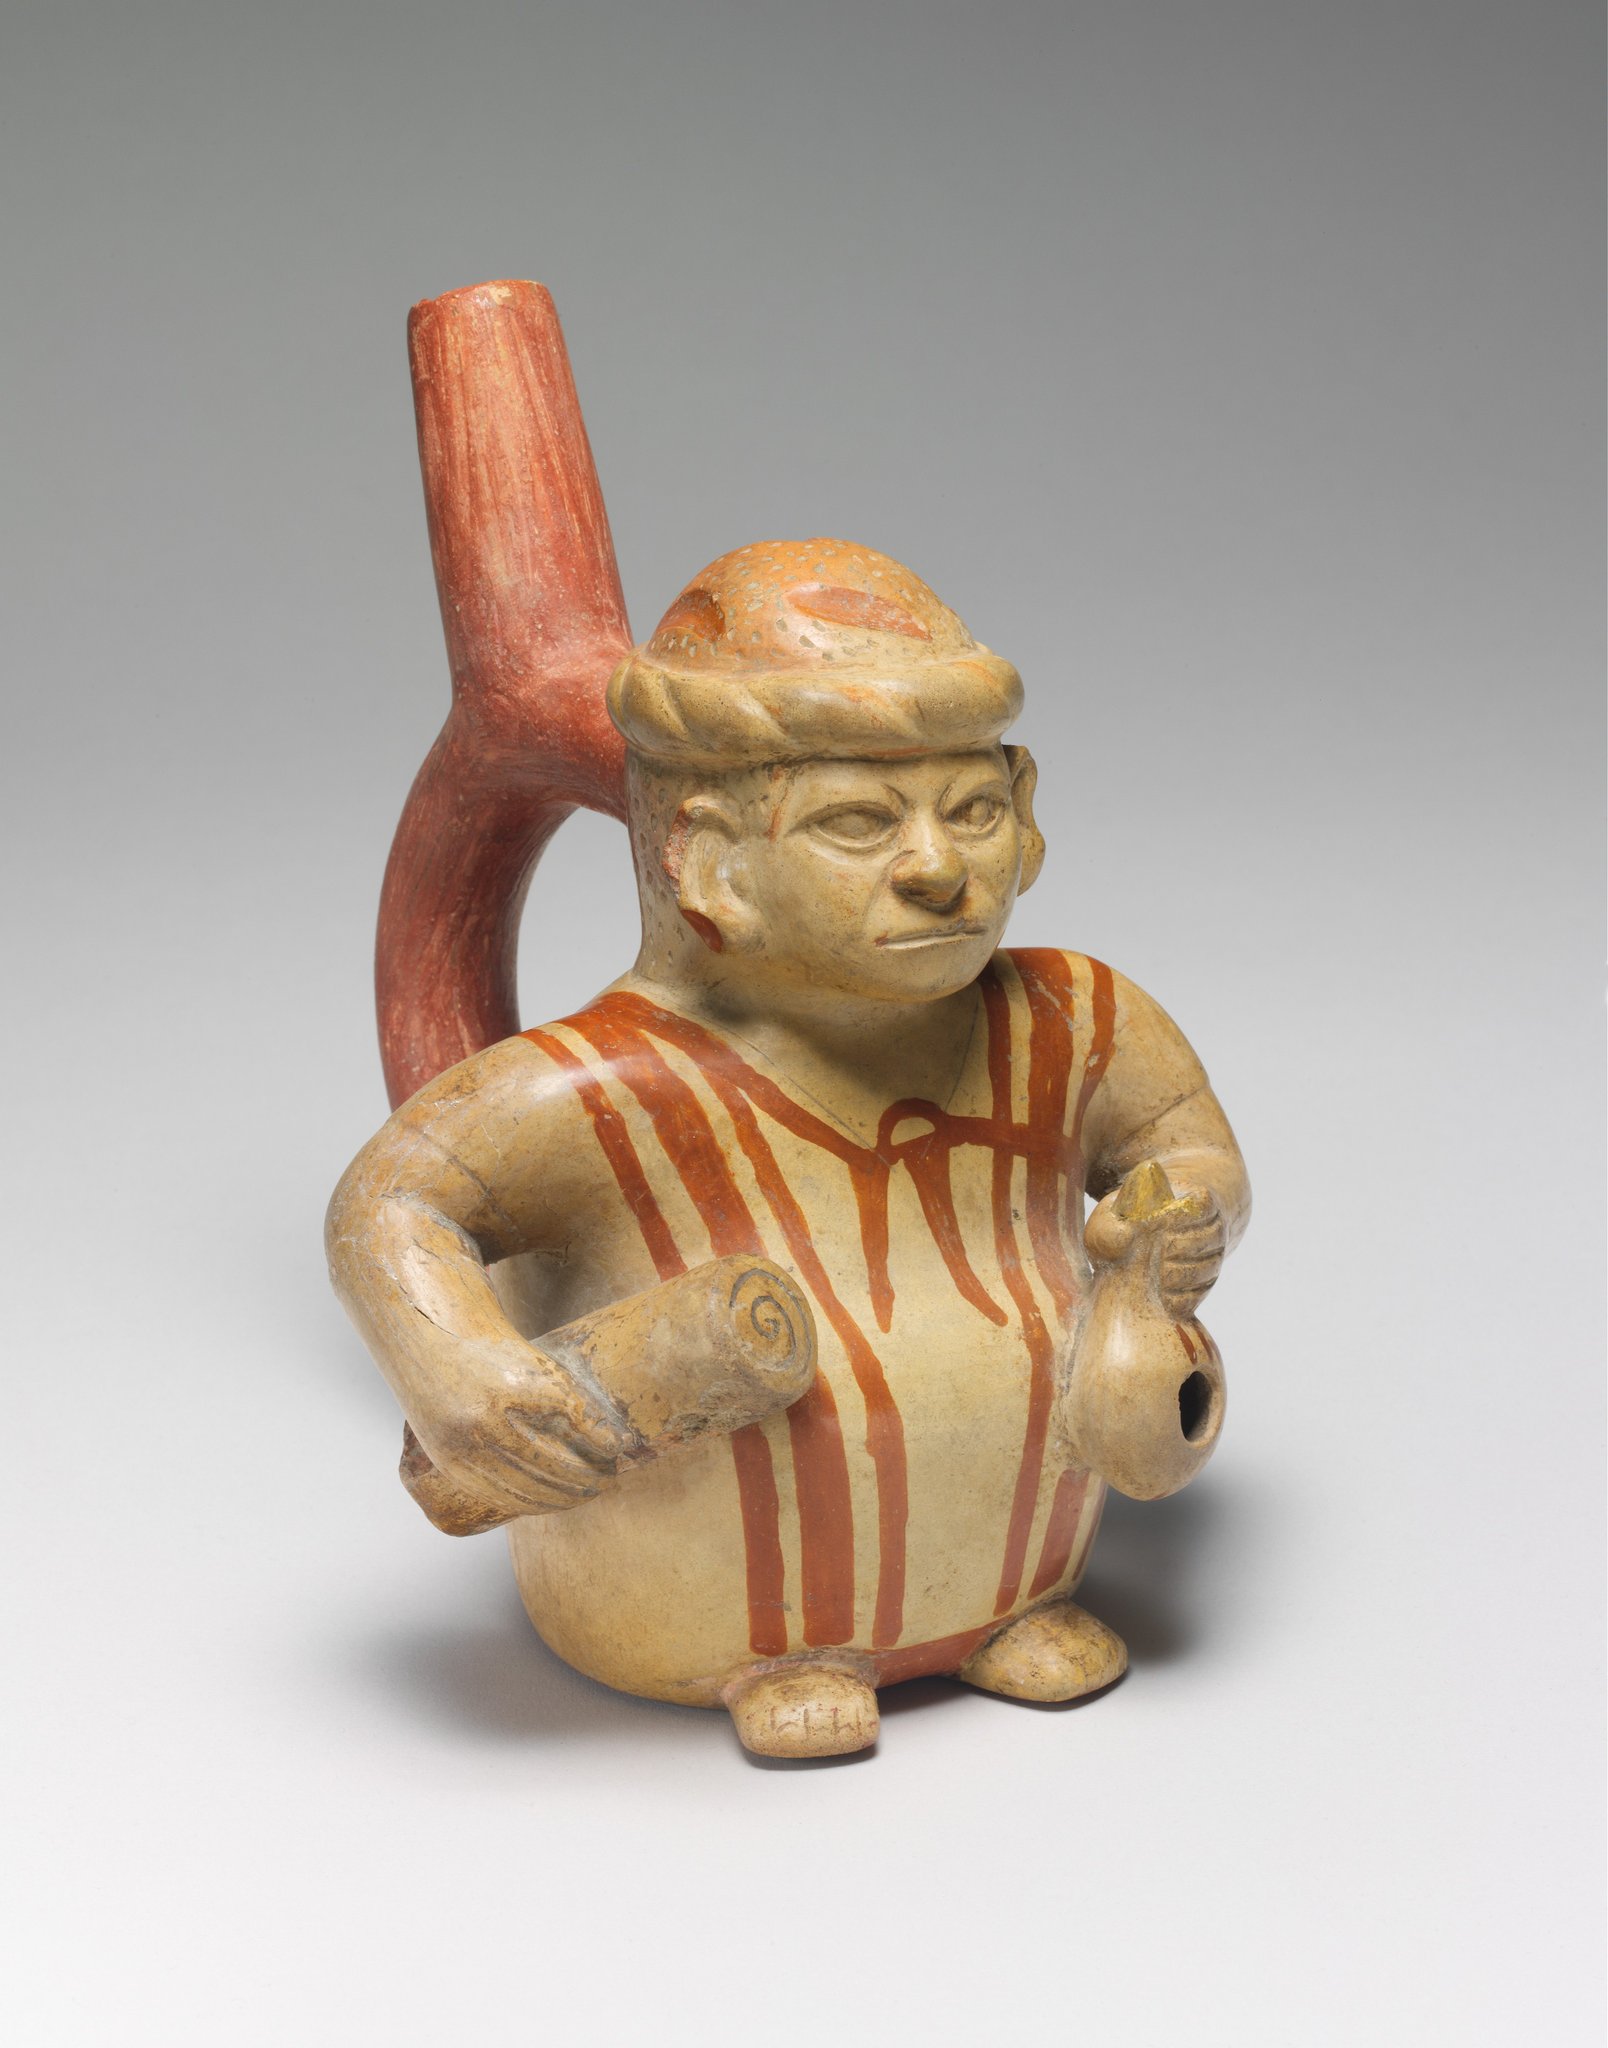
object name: bottle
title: Figure Bottle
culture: moche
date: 201-500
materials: ceramic, pigment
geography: peru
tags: men